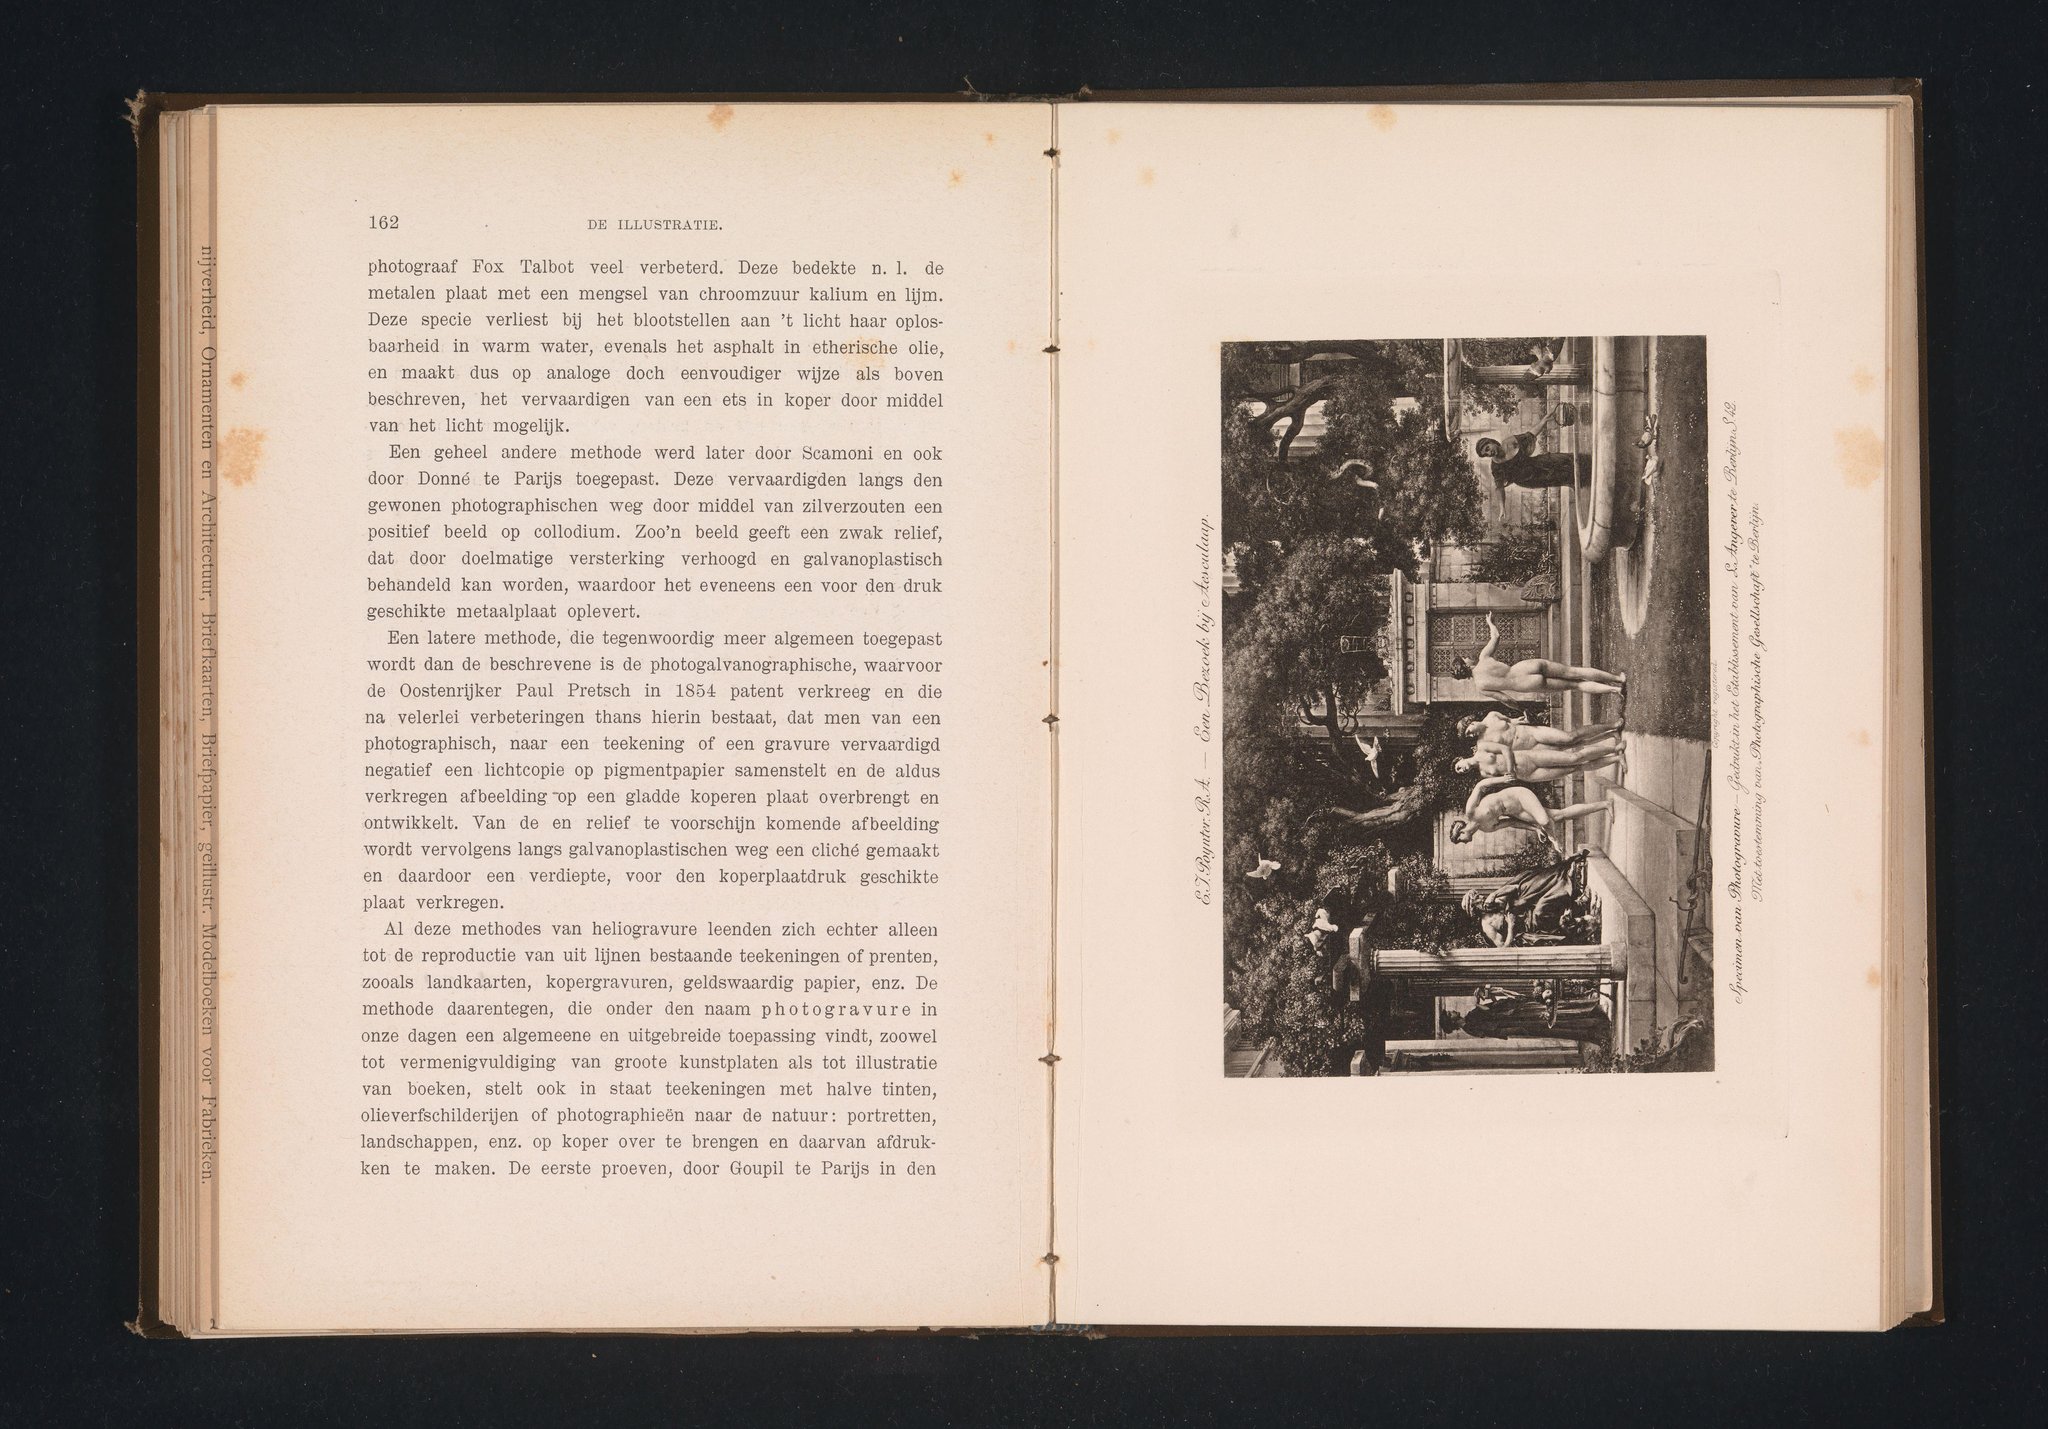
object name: reproduction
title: Specimen van Photogravure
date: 1887-1892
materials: paper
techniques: photoaquatint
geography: berlin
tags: non-aggressive, friendly or neutral activities and relationships of aesculapius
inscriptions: inscription: ‘Copyright registered.’, inscription: ‘Gedrukt in het Etablissement van L. Angerer te Berlijn S. 42./ Met toestemming van "Photographische Gesellschaft" te Berlijn.’